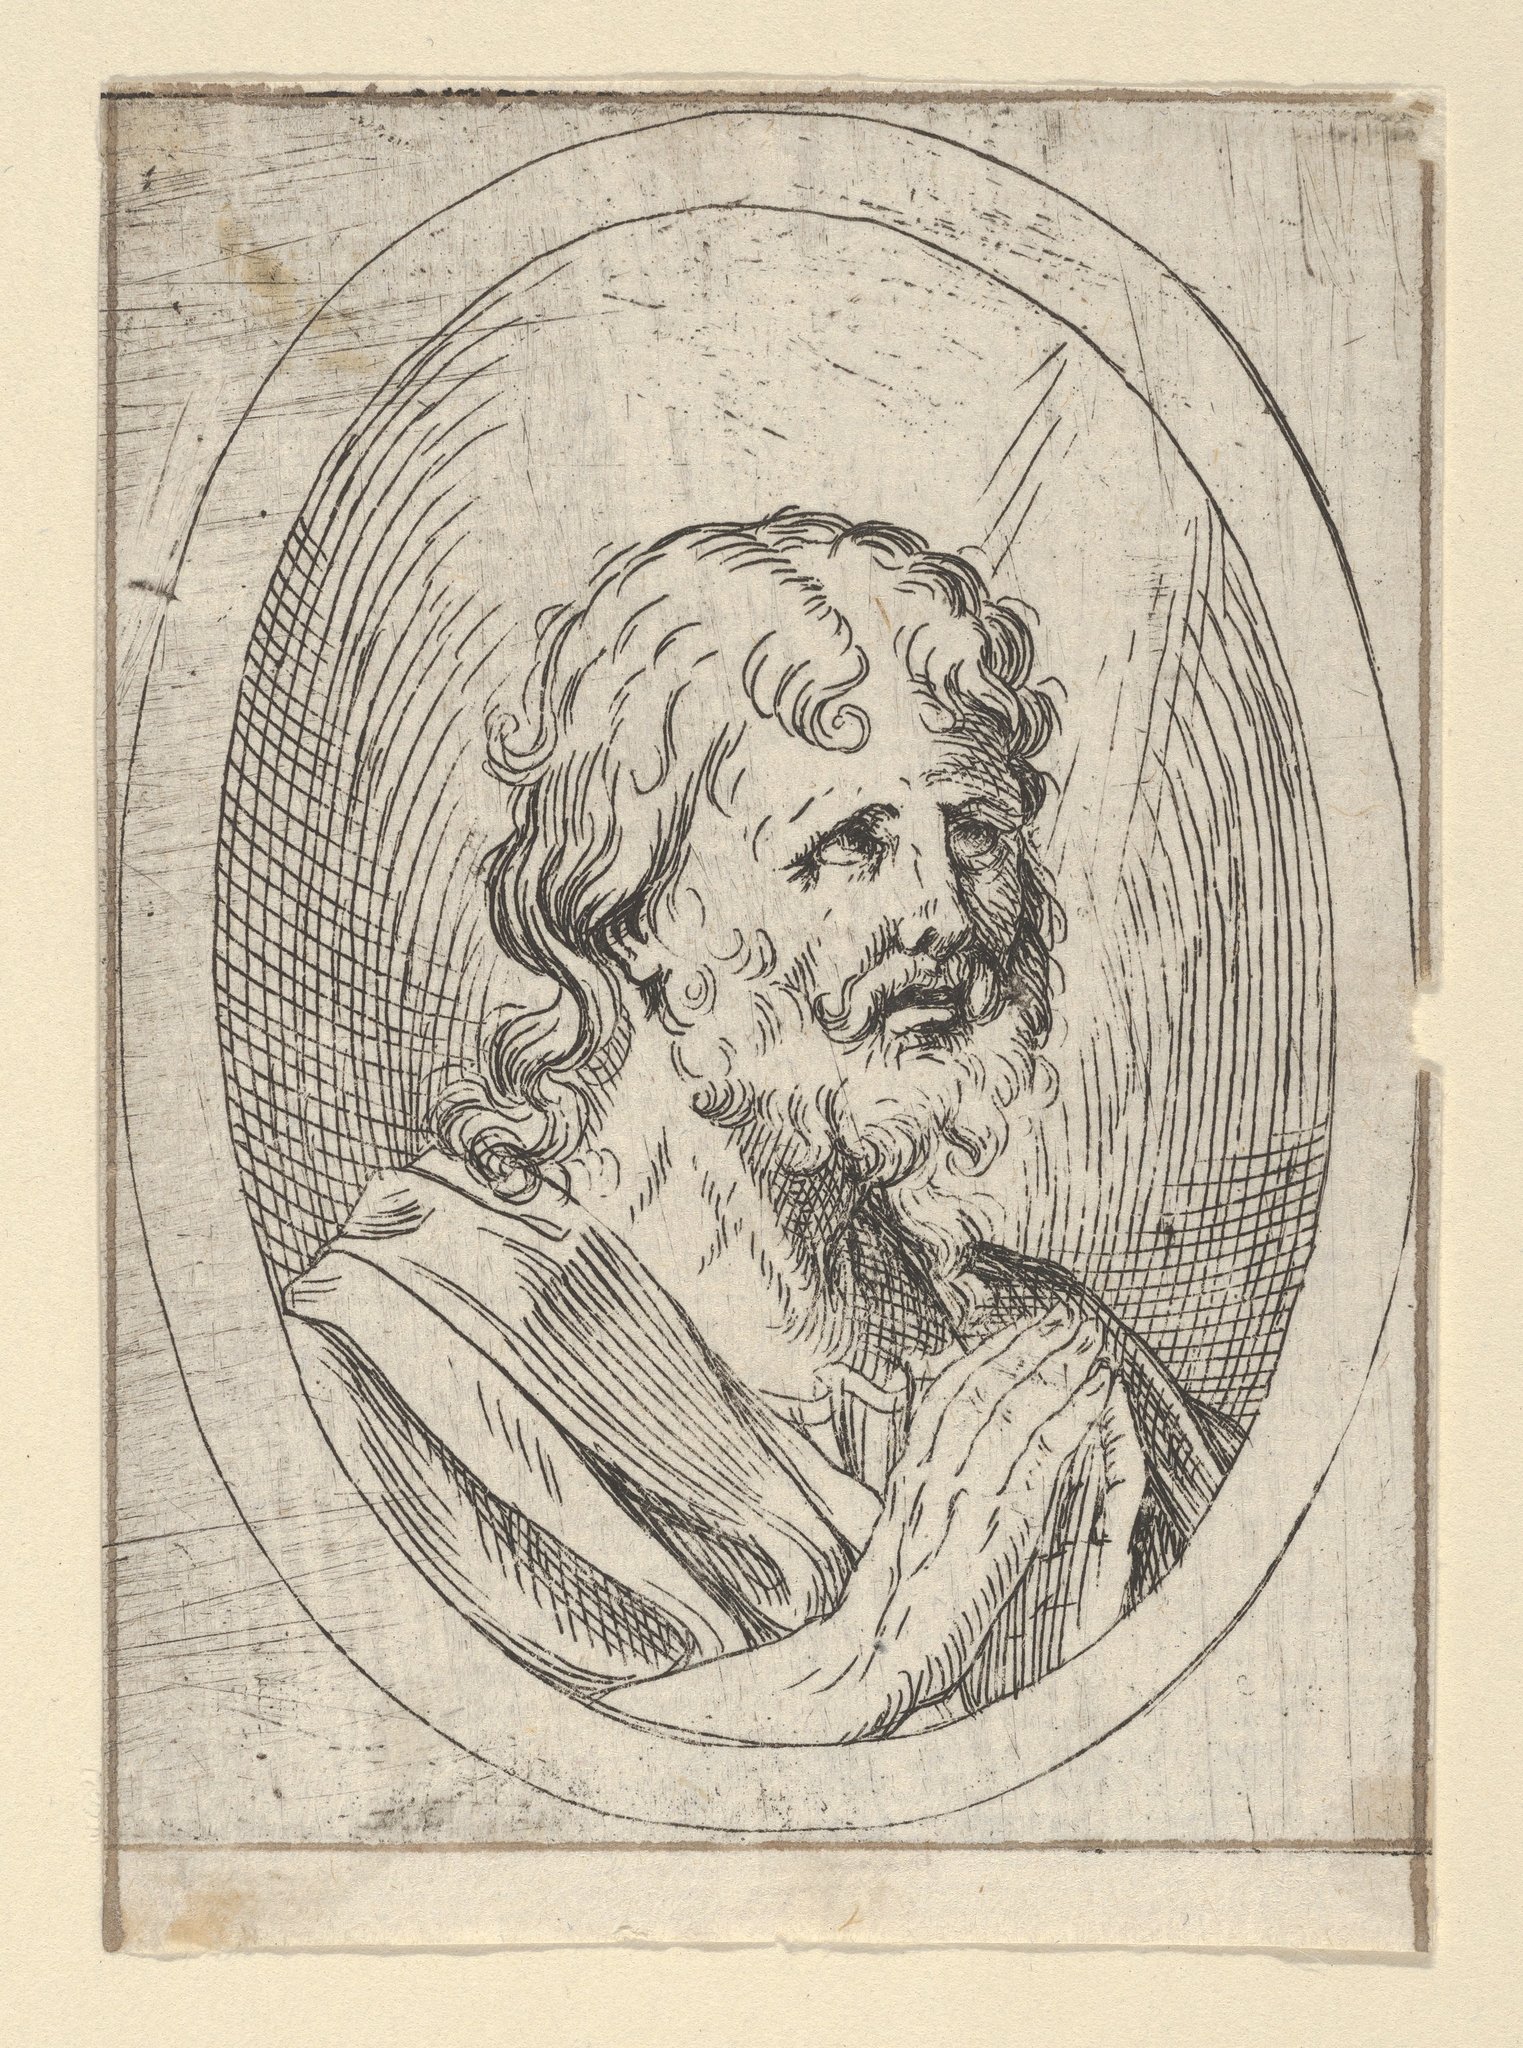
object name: print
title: An apostle raising his eyes in prayer, in an oval frame, from "Christ, the Virgin, and Thirteen Apostles"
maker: anonymous, 17th century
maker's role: artist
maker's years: 1600-1700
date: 1600-1640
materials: ink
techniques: etching, pen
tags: portraits,apostles,praying